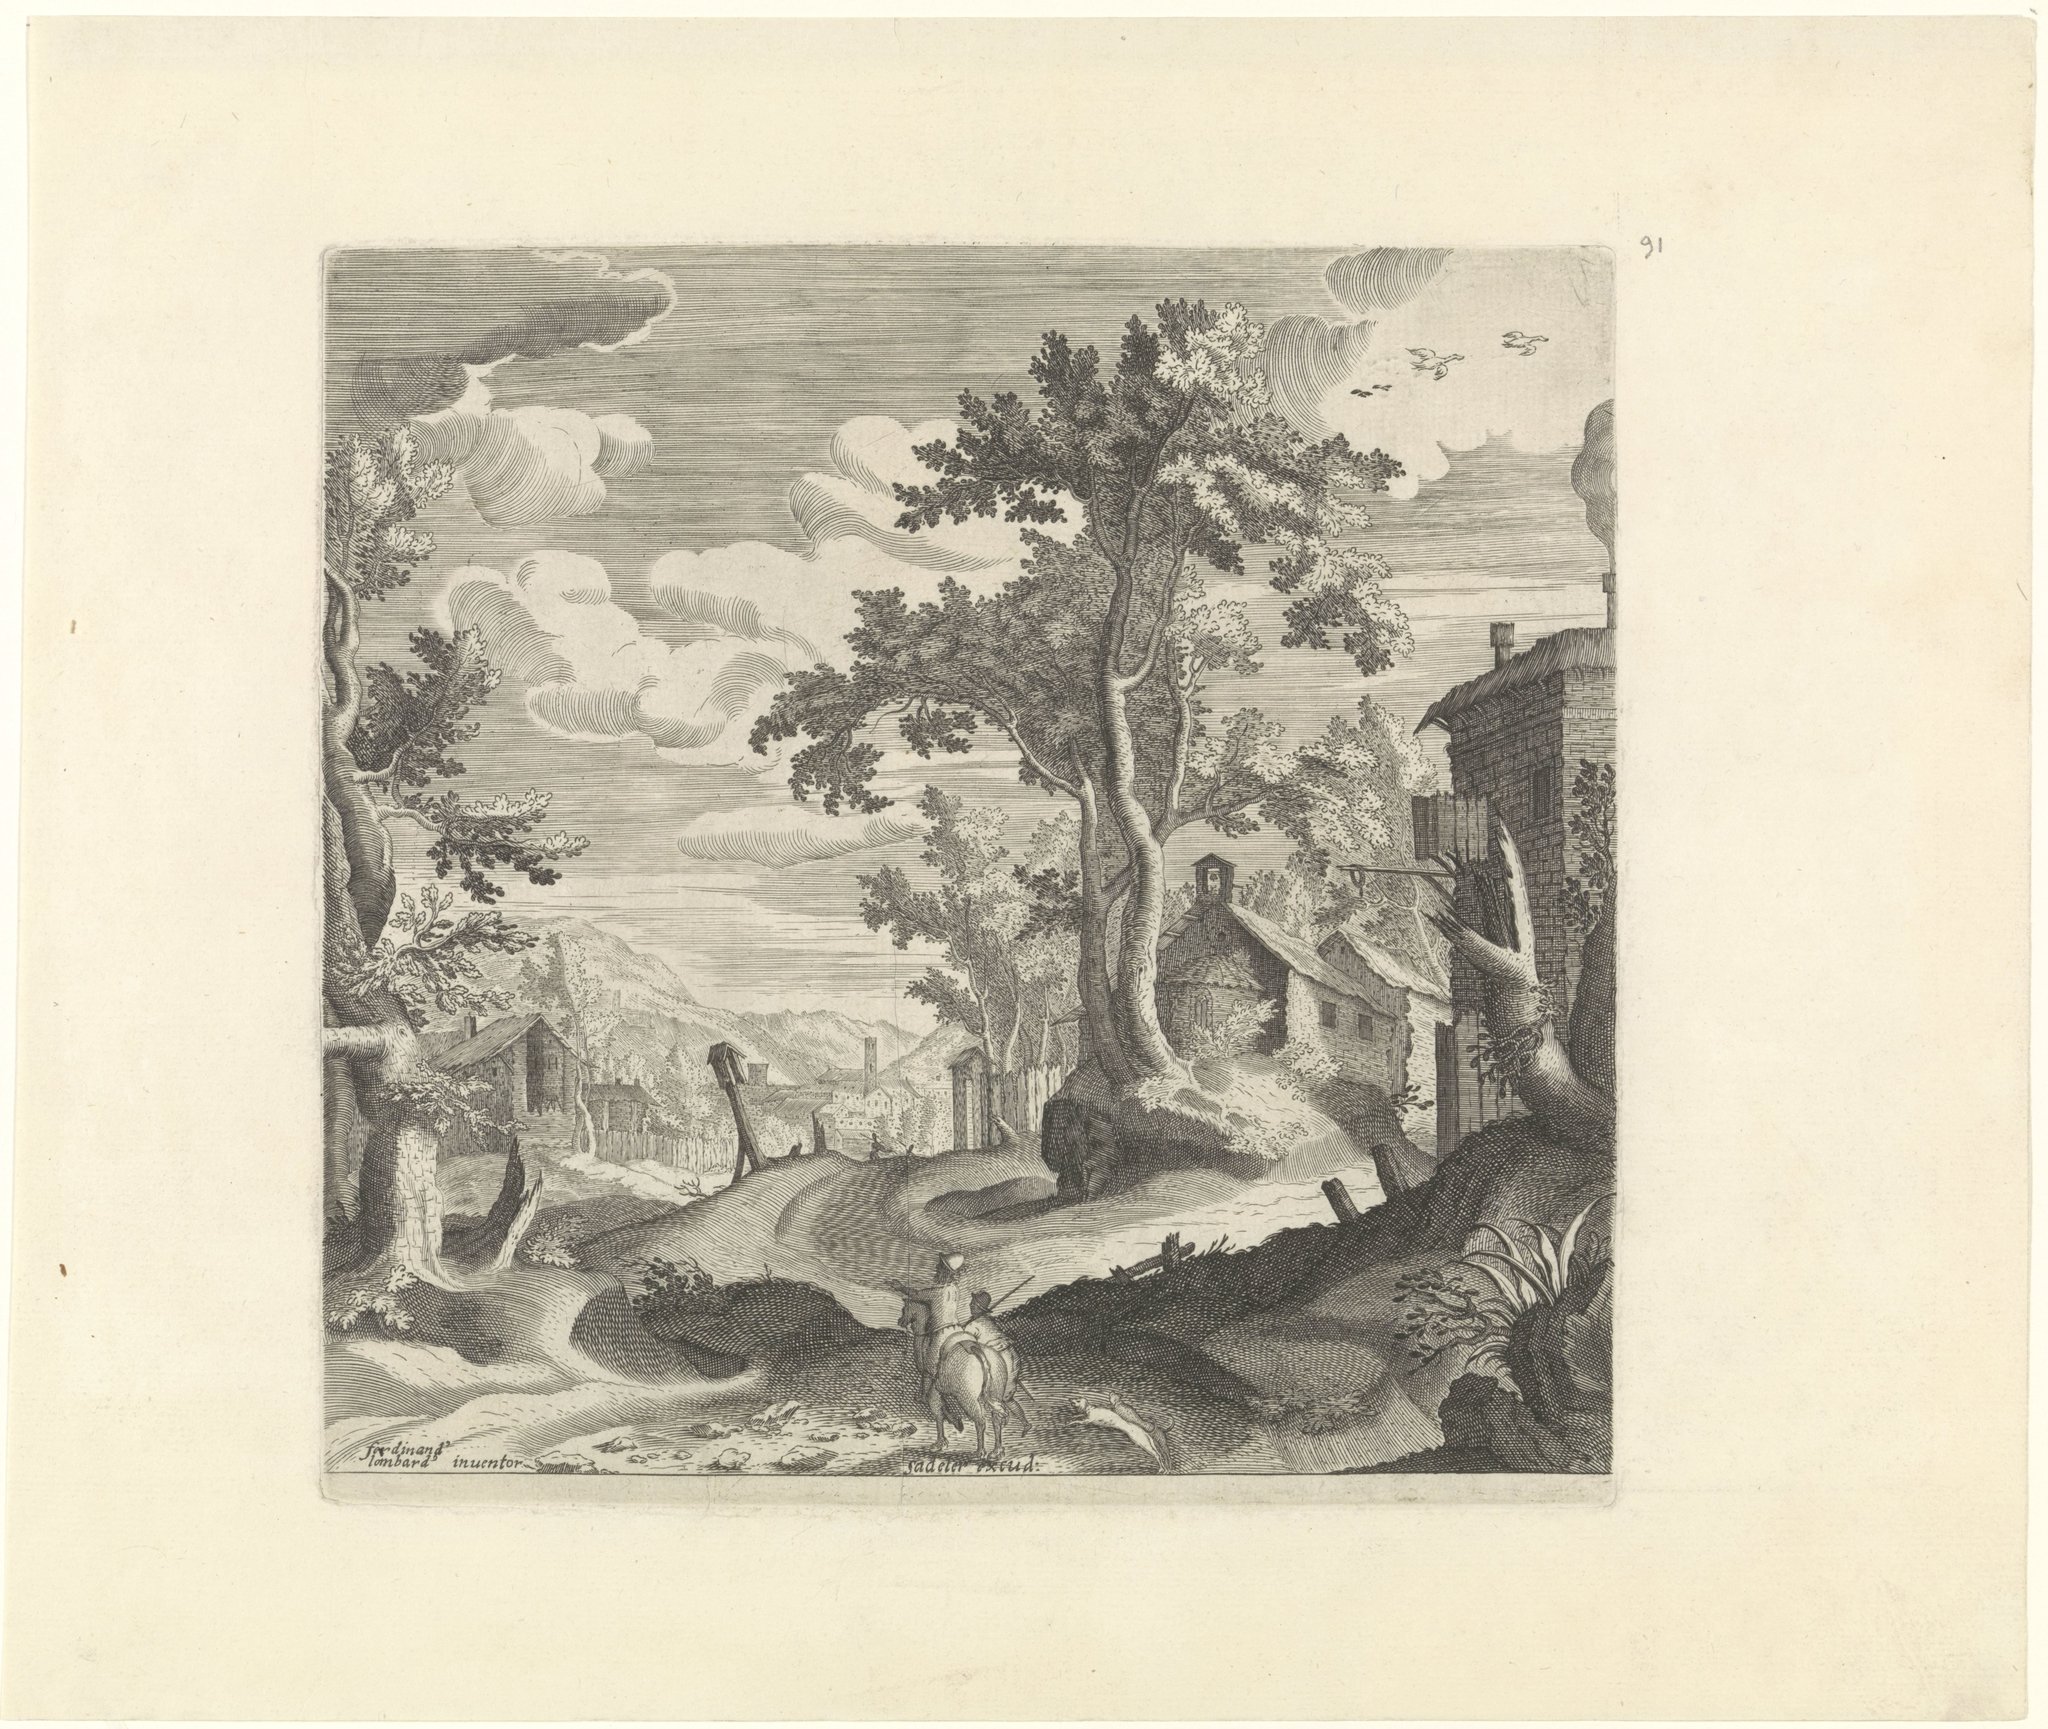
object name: print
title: Landschap met twee jagers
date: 1580-1600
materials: paper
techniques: engraving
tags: hunting dogs, hunter, outskirts of city, public road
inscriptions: collector's mark: Lugt 2760, collector's mark: Lugt 2228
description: Een landschap met een weg naar een stadje. Op de voorgrond twee jagers met twee honden. Een van de jagers zit op een paard.